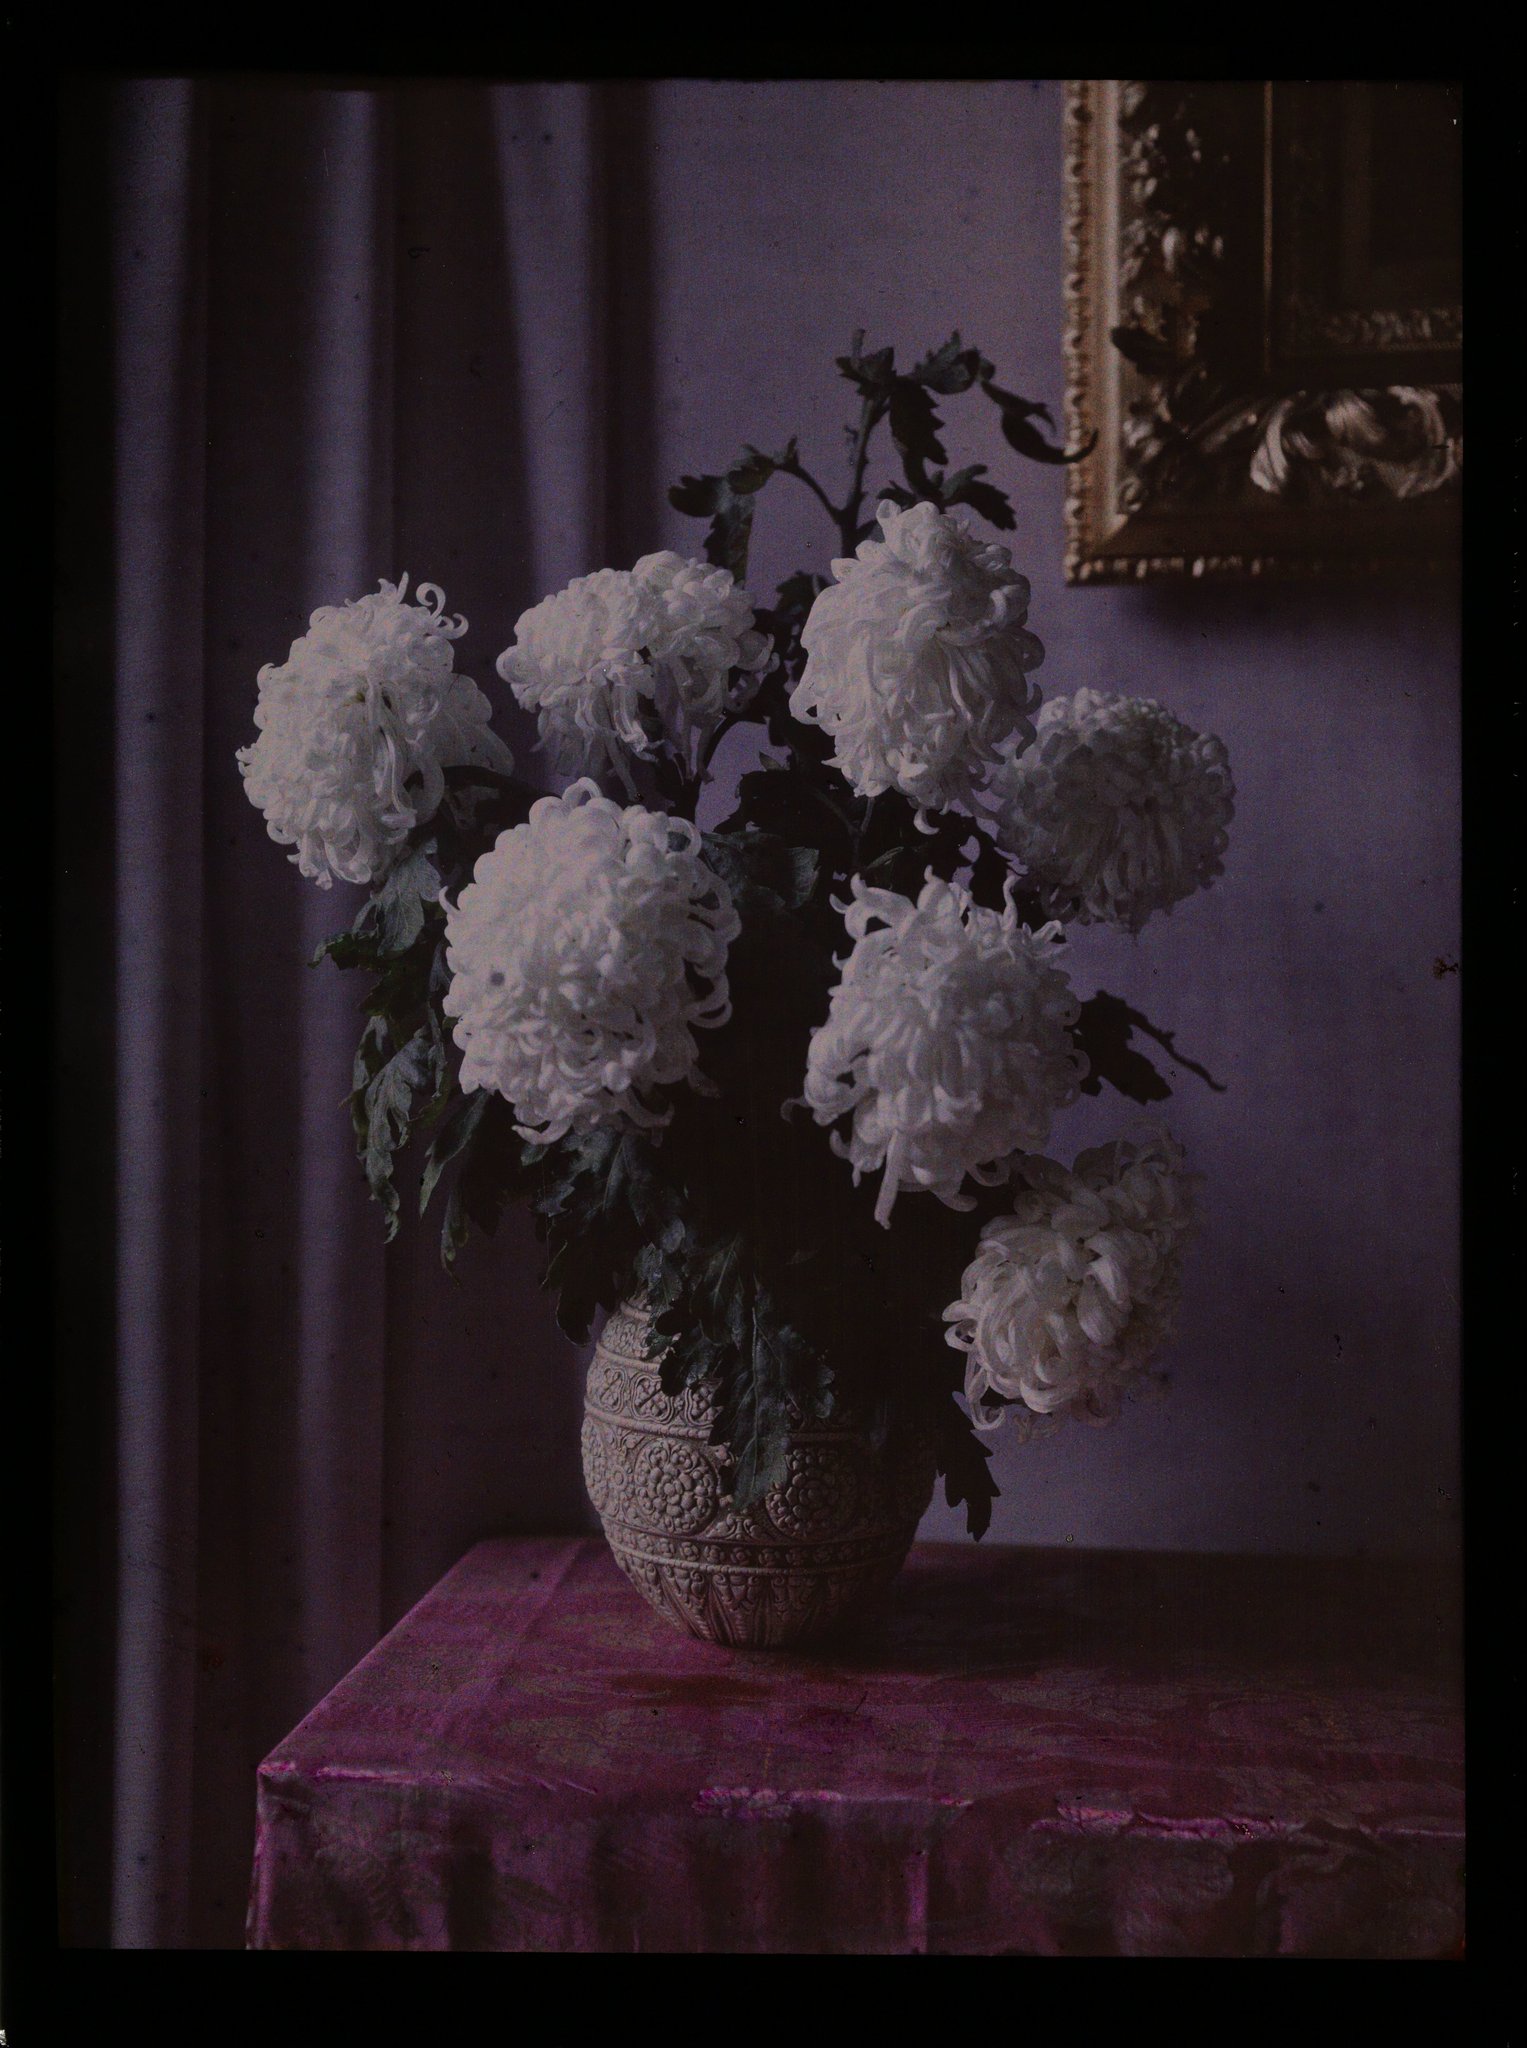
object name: photograph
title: Vaas met pioenrozen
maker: Anonymous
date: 1907-1935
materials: glass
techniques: autochrome process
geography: netherlands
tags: flowers in a vase, netherlands